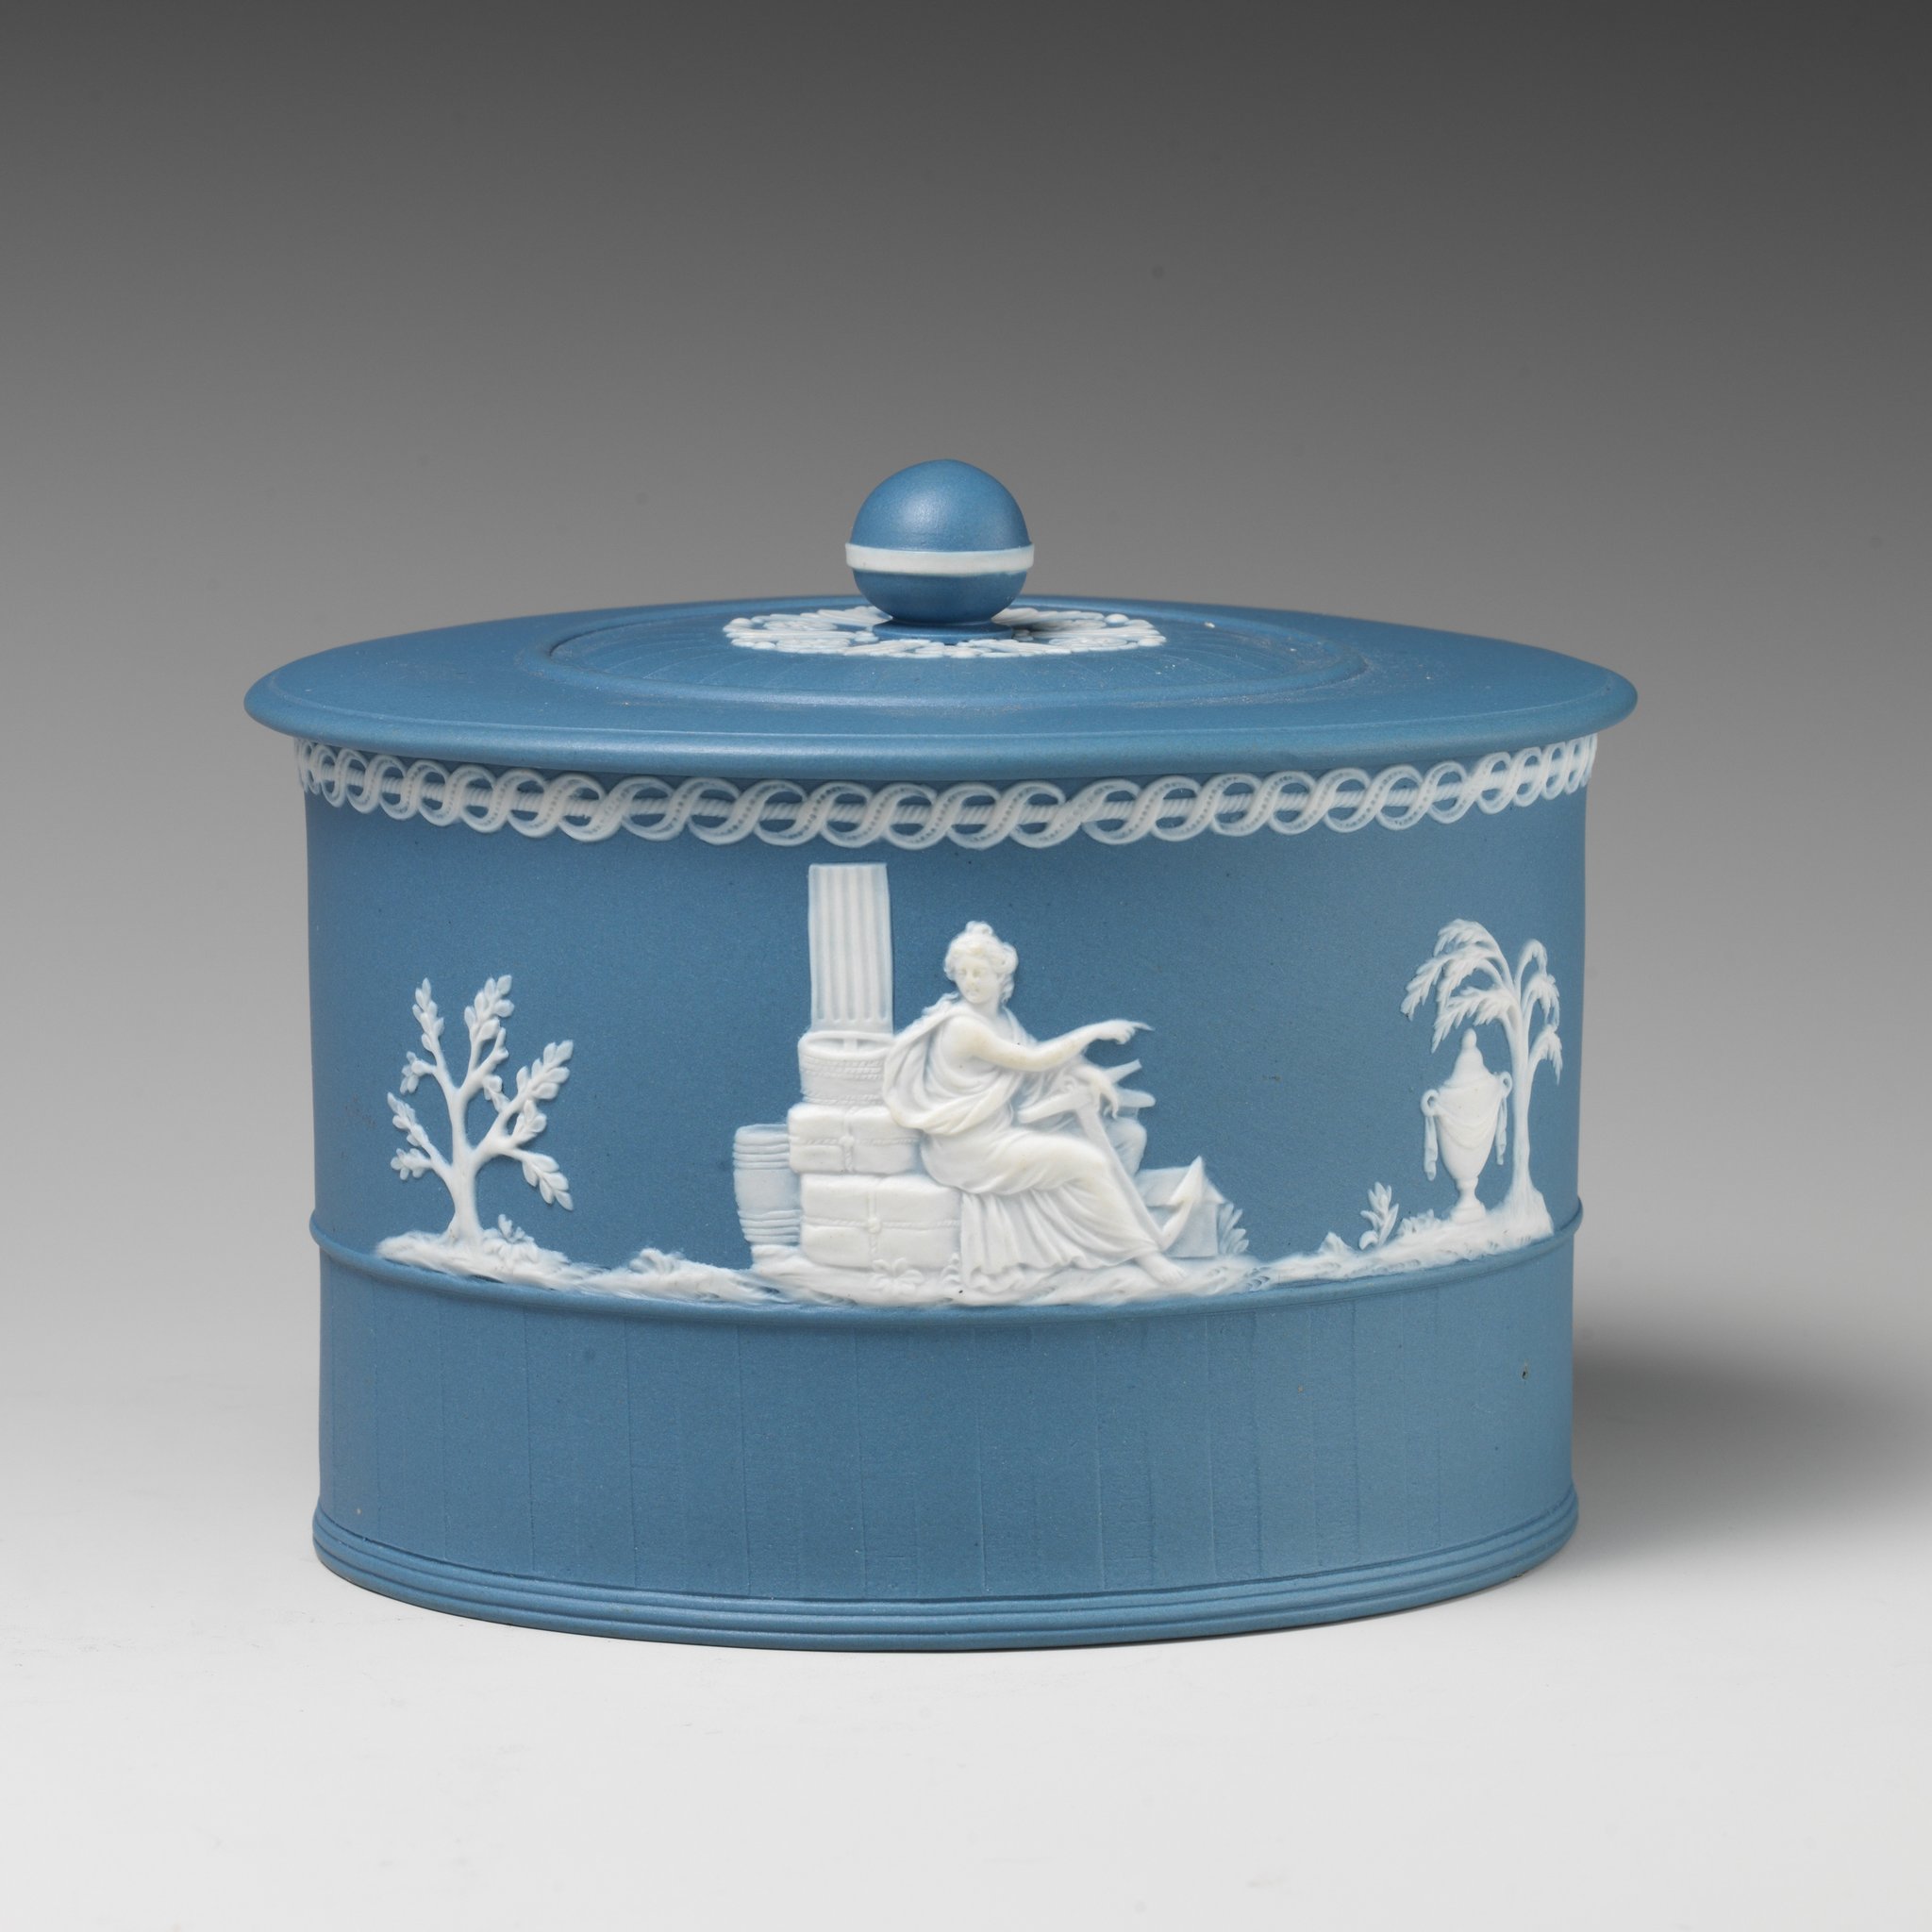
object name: sugar bowl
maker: william adams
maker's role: maker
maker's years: 1745-1805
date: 1701-1800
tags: girls,women